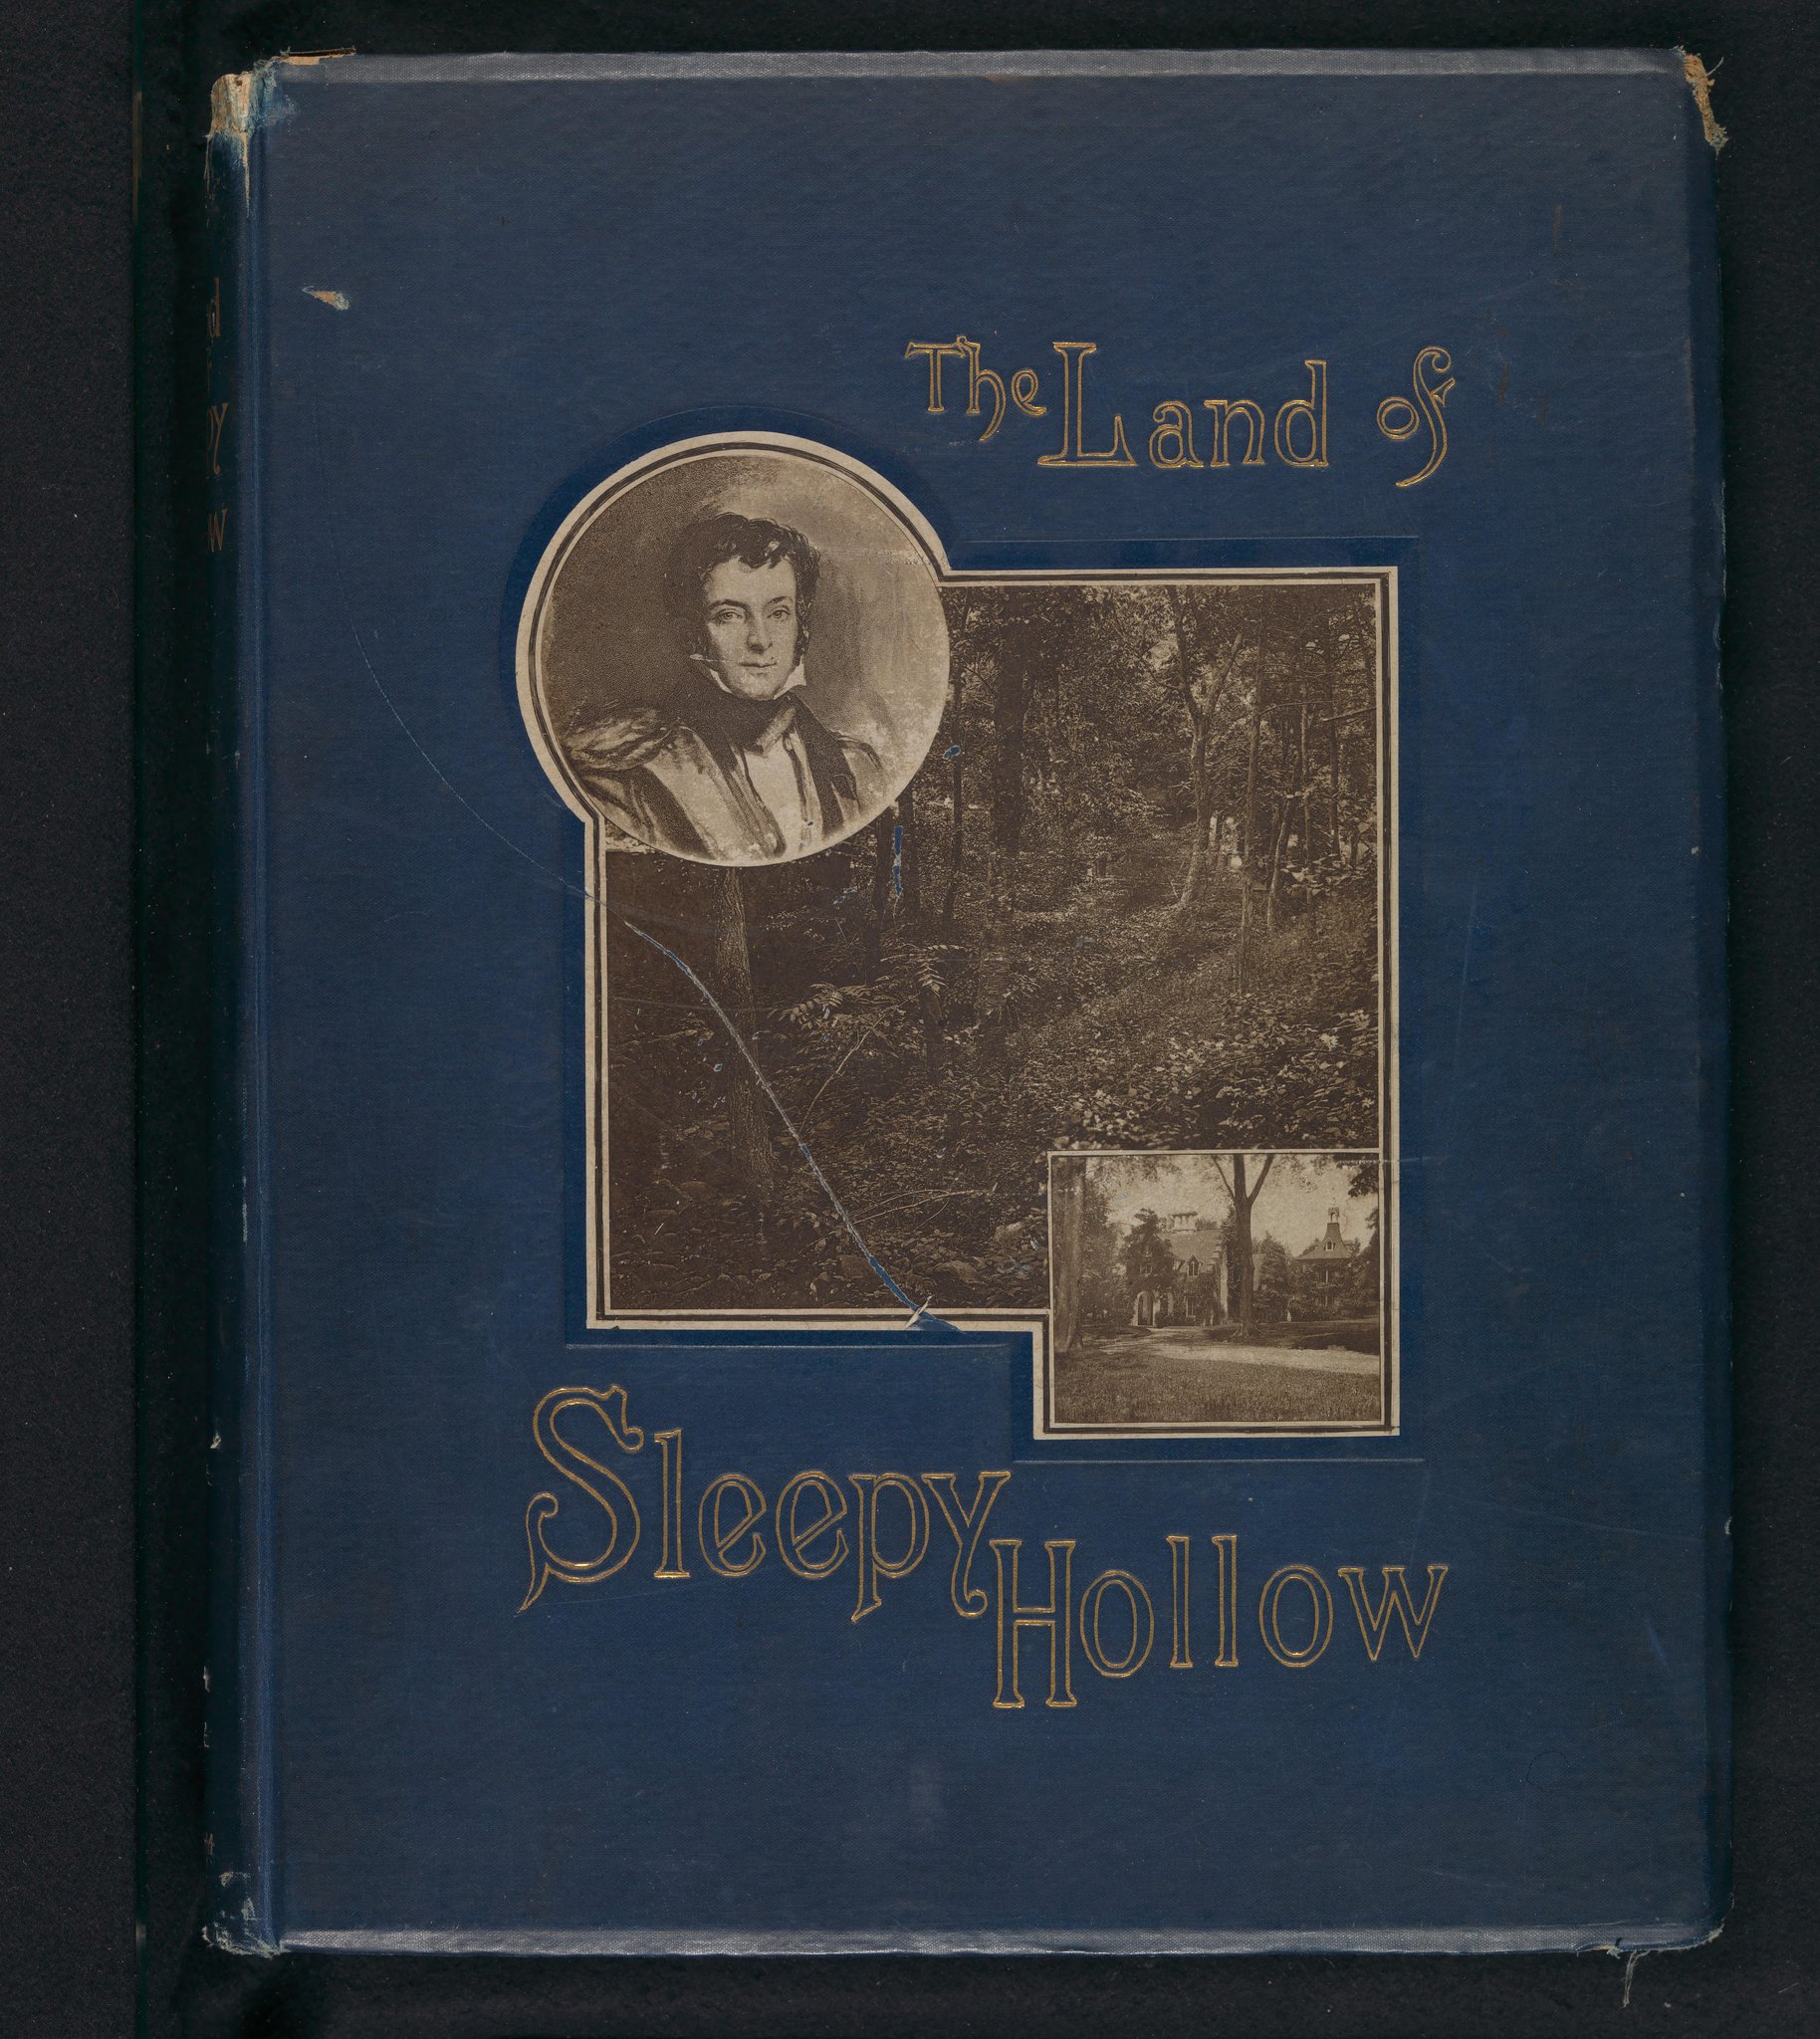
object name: photomechanical print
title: Gezicht op een bos te Sleepy Hollow, huizen te Sleepy Hollow en een fotoreproductie van een schilderij, voorstellende een portret van Washington Irving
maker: james leon williams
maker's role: fotograaf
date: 1882-1887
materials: paper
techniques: photoaquatint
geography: sleepy hollow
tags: washington irving, forest, wood, writer, poet, author, façade (of house or building)